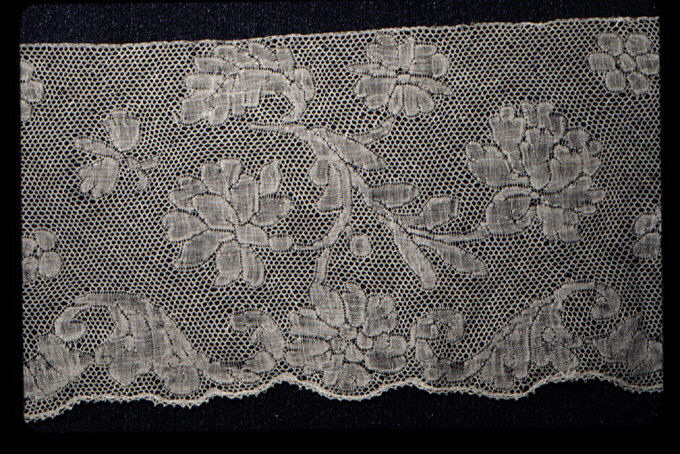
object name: fragment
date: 1767-1800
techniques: lace